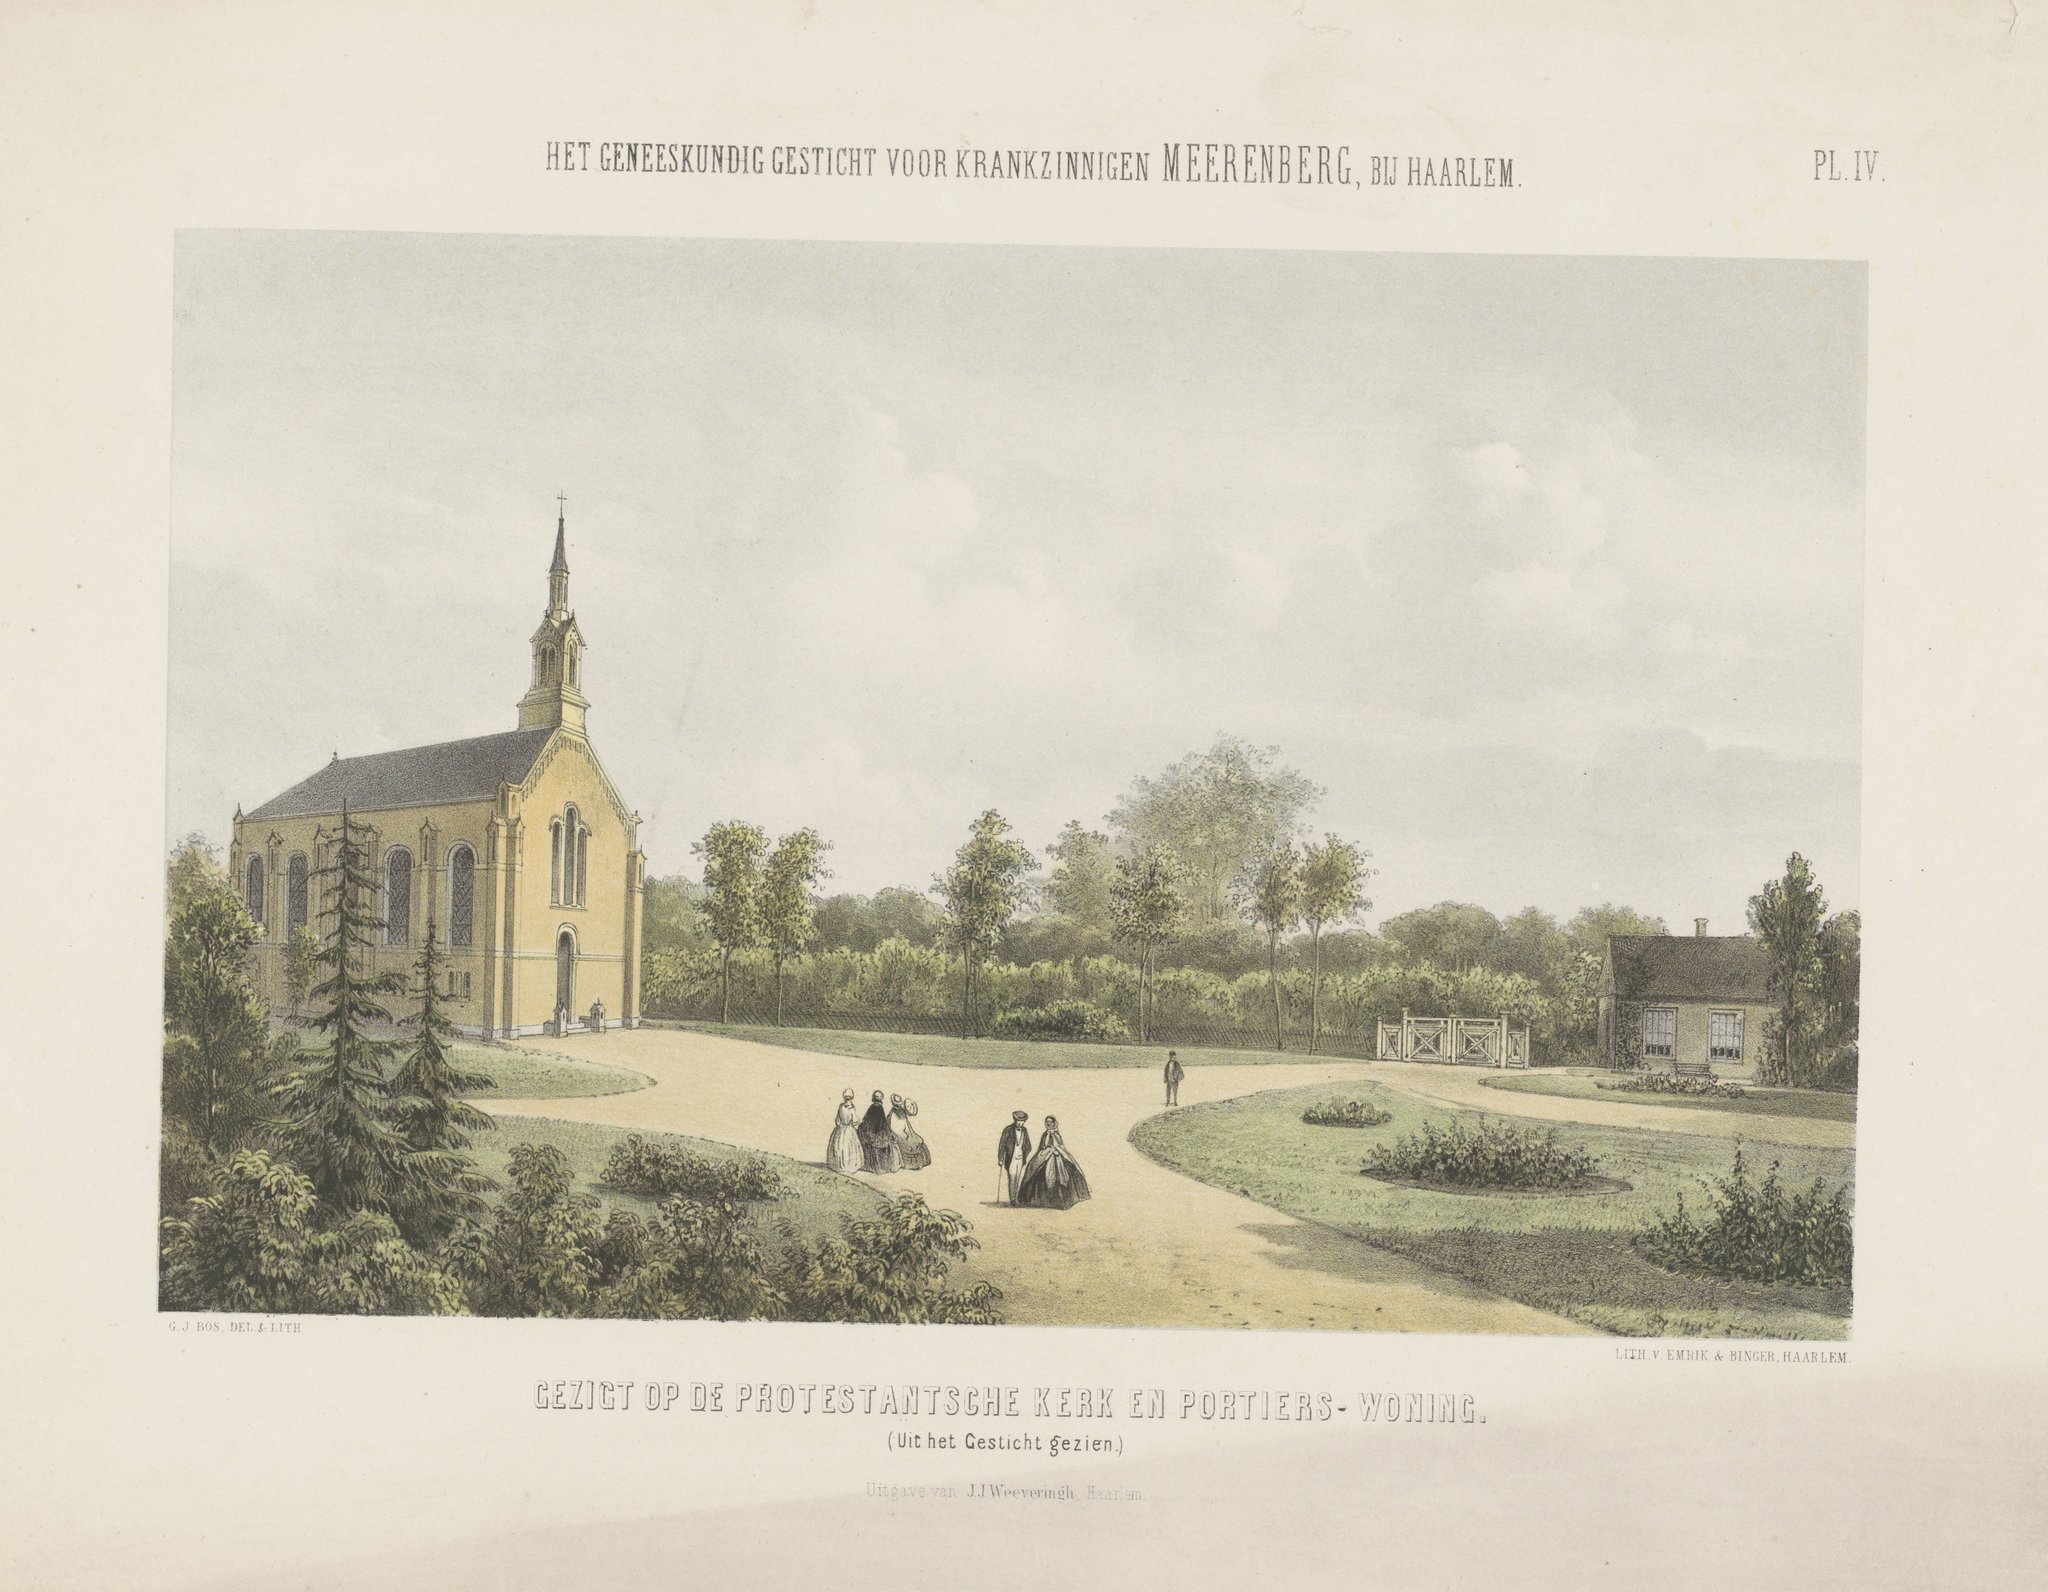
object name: print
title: Kerk en portierswoning achter de Meerenberg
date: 1835-1898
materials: paper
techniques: chromolithography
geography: haarlem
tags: protestant churches and denominations, gate, entrance, hospital, landscapes (+ landscape with figures, staffage)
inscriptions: collector's mark: Lugt 2228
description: Op de zandpaden lopen verschillende figuren. Tussen de paden liggen grasvelden met struiken en bomen. Links ligt de kerk en rechts de kleine portierswoning met twee ramen en een hekwerk ervoor. Rechtsboven: Pl. IV.